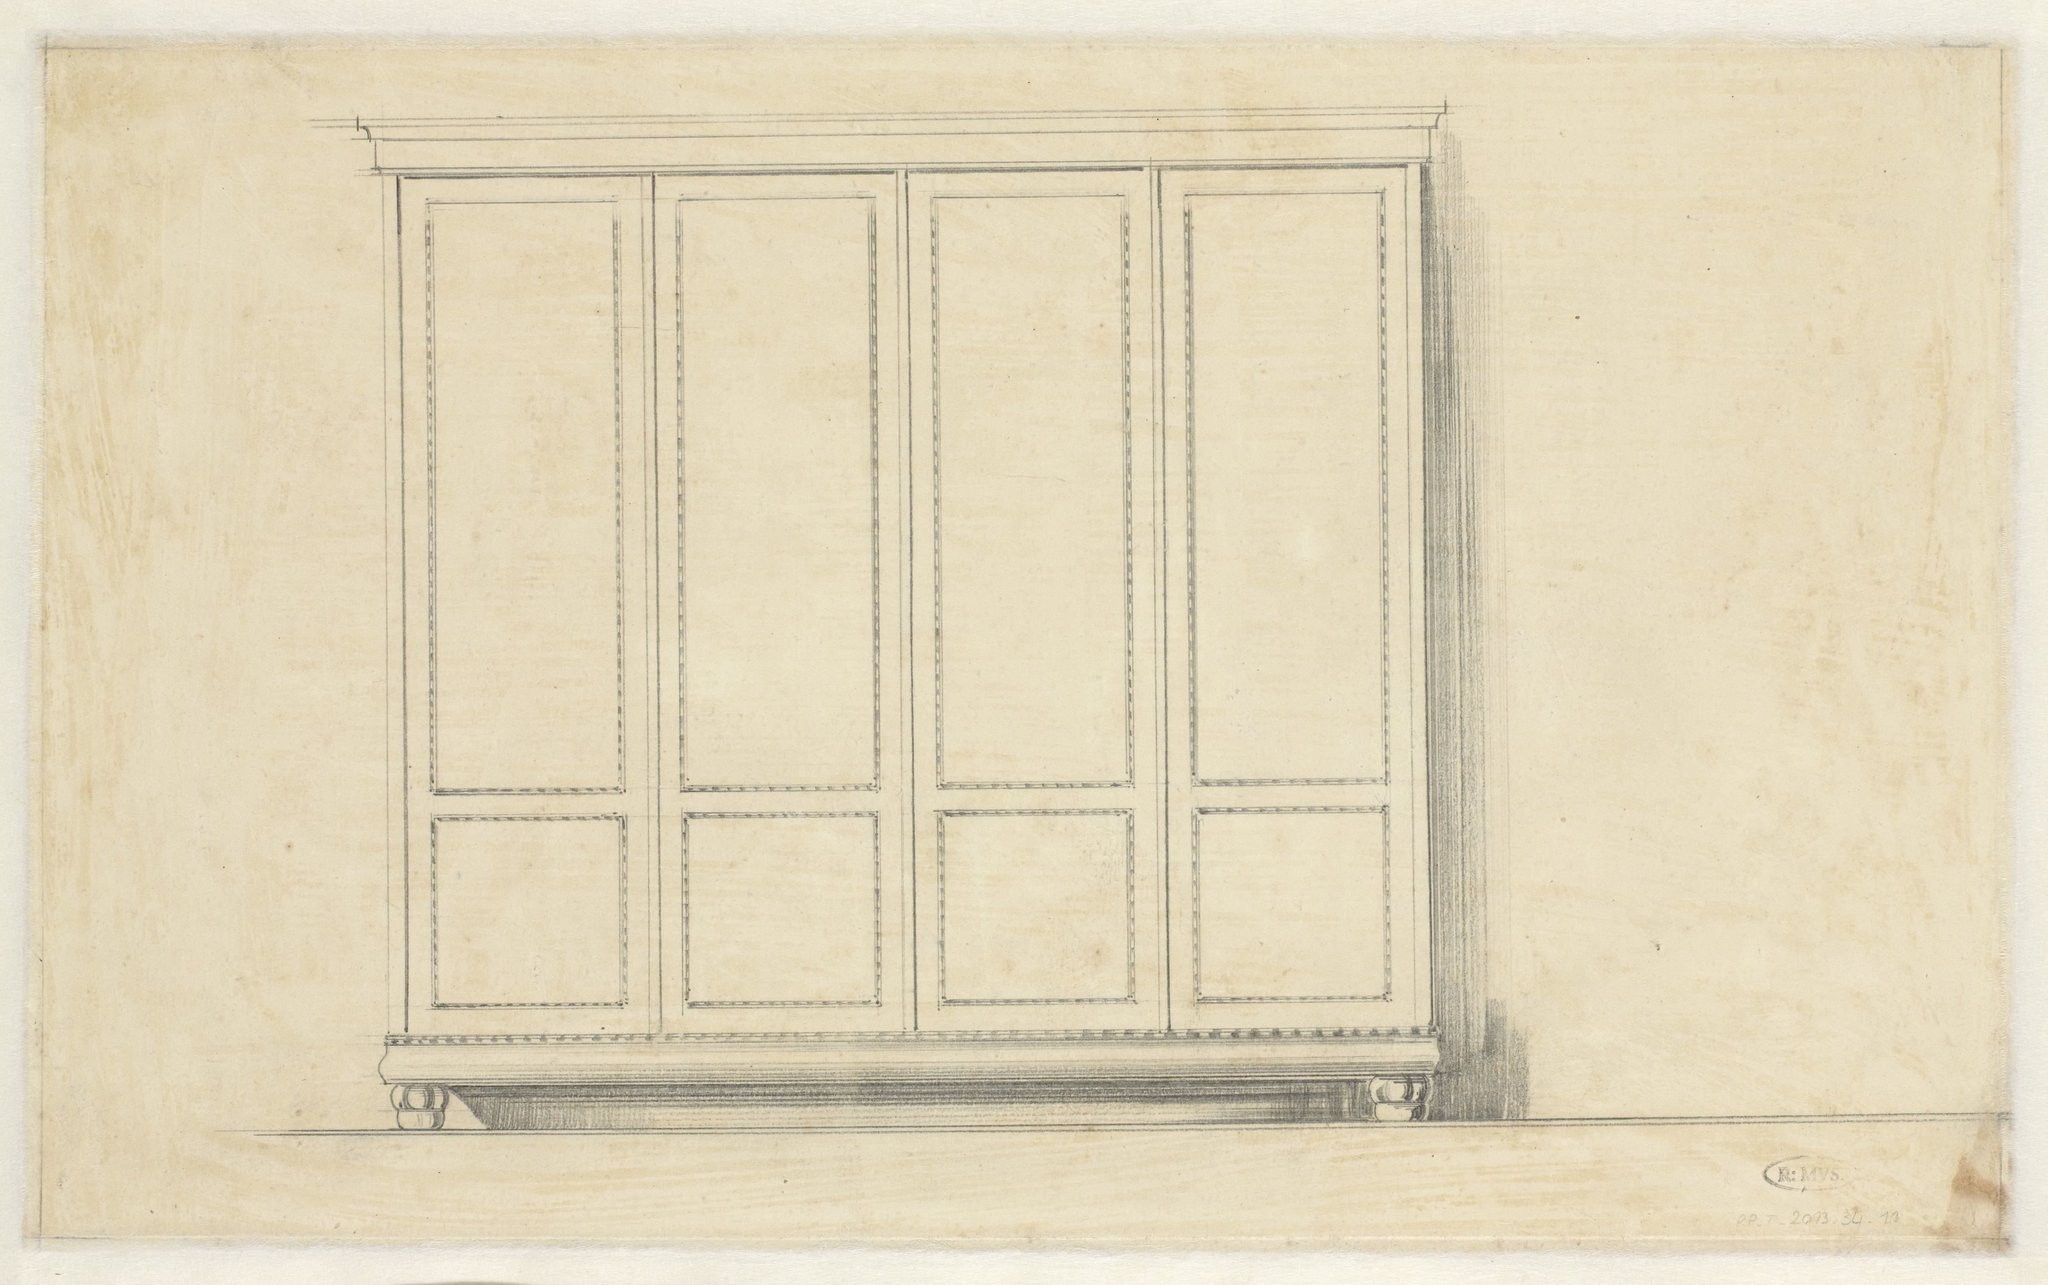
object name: drawing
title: Kast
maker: monogrammist hk (nederland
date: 1925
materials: paper, pencil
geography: amsterdam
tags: cupboard